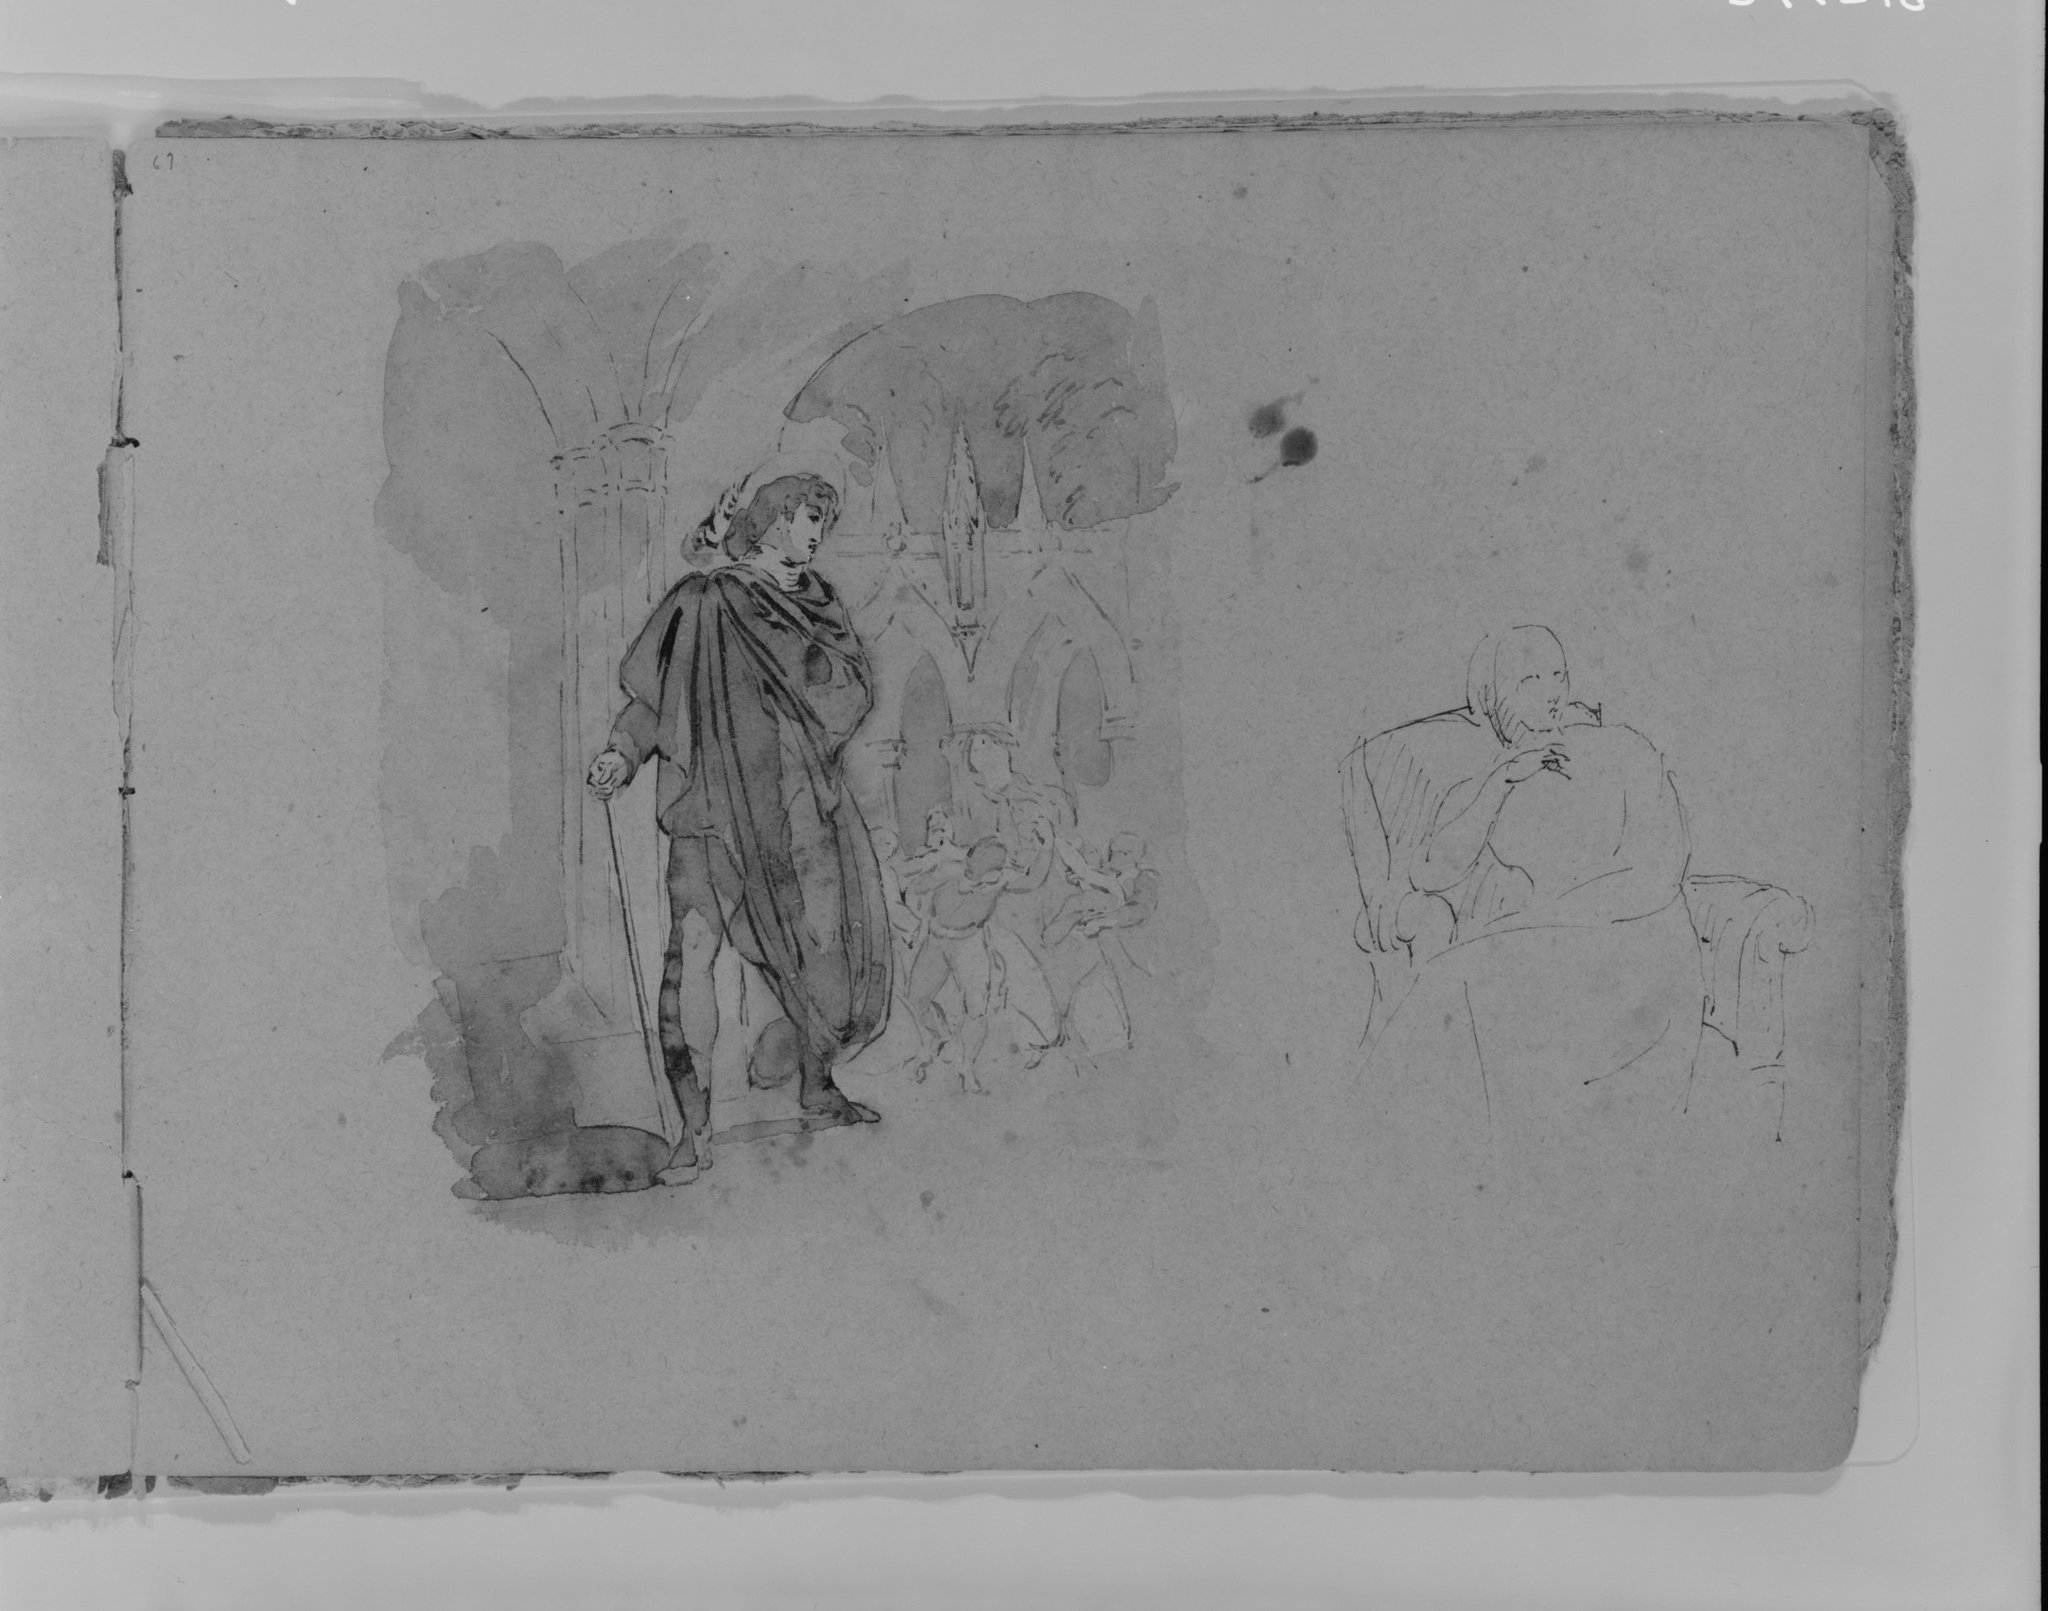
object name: drawing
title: Man in Cape with Staff Watching Melee; Seated Woman (from Sketchbook)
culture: american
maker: thomas sully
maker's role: artist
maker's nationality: american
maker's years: 1783-1872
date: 1810-1820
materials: ink, paper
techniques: wash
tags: men,women